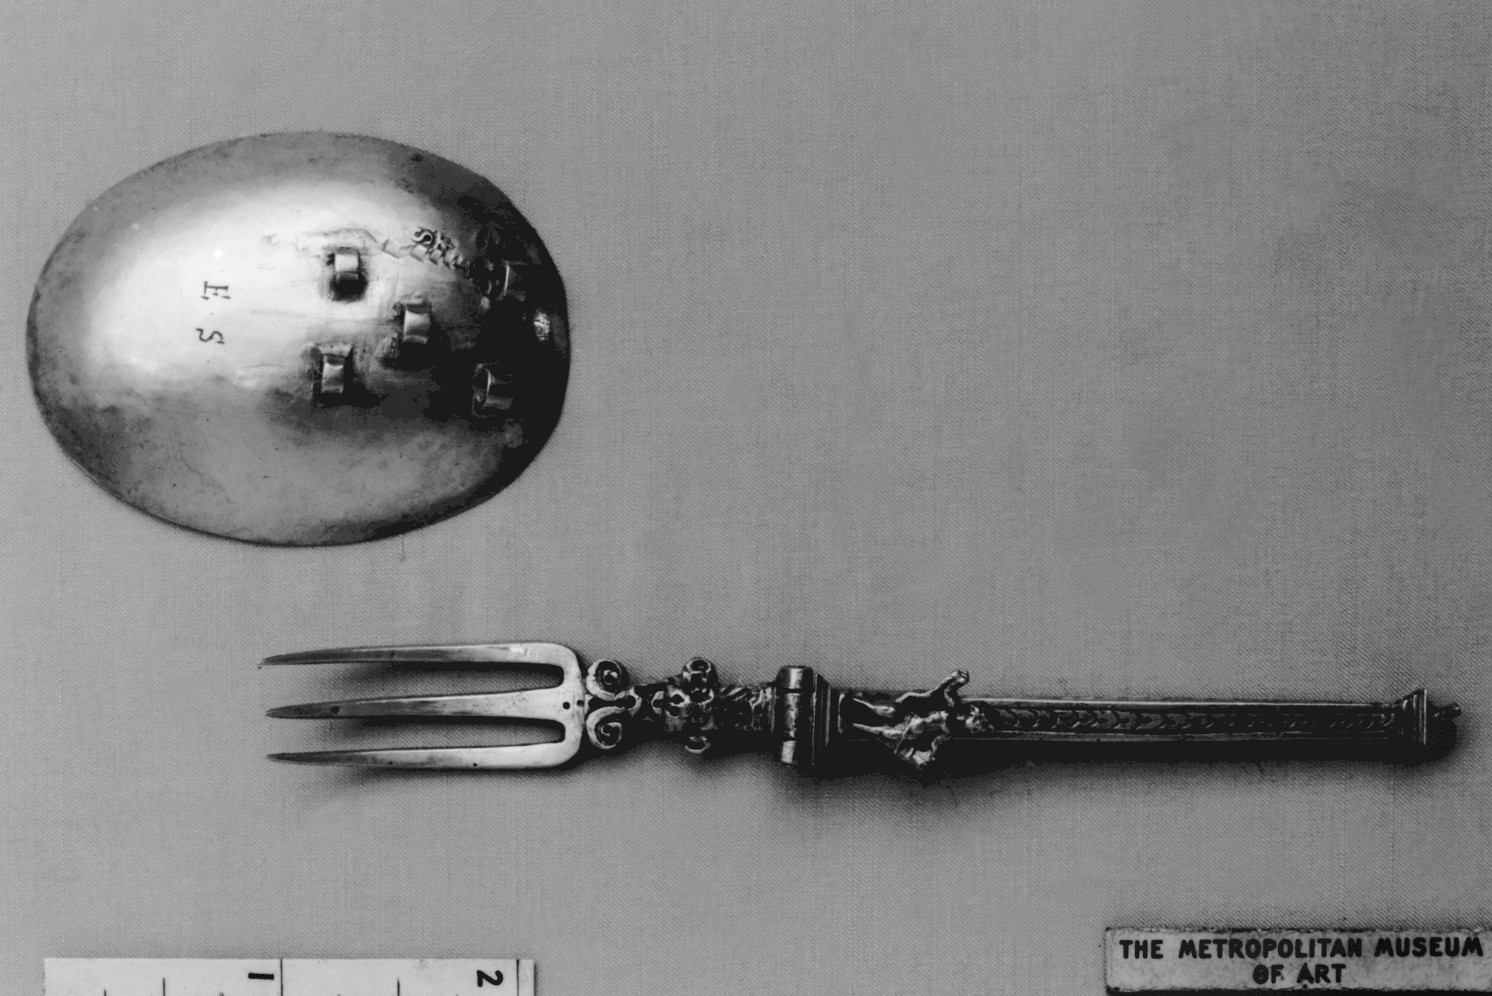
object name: spoon and fork combination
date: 1628-1629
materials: silver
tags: human figures